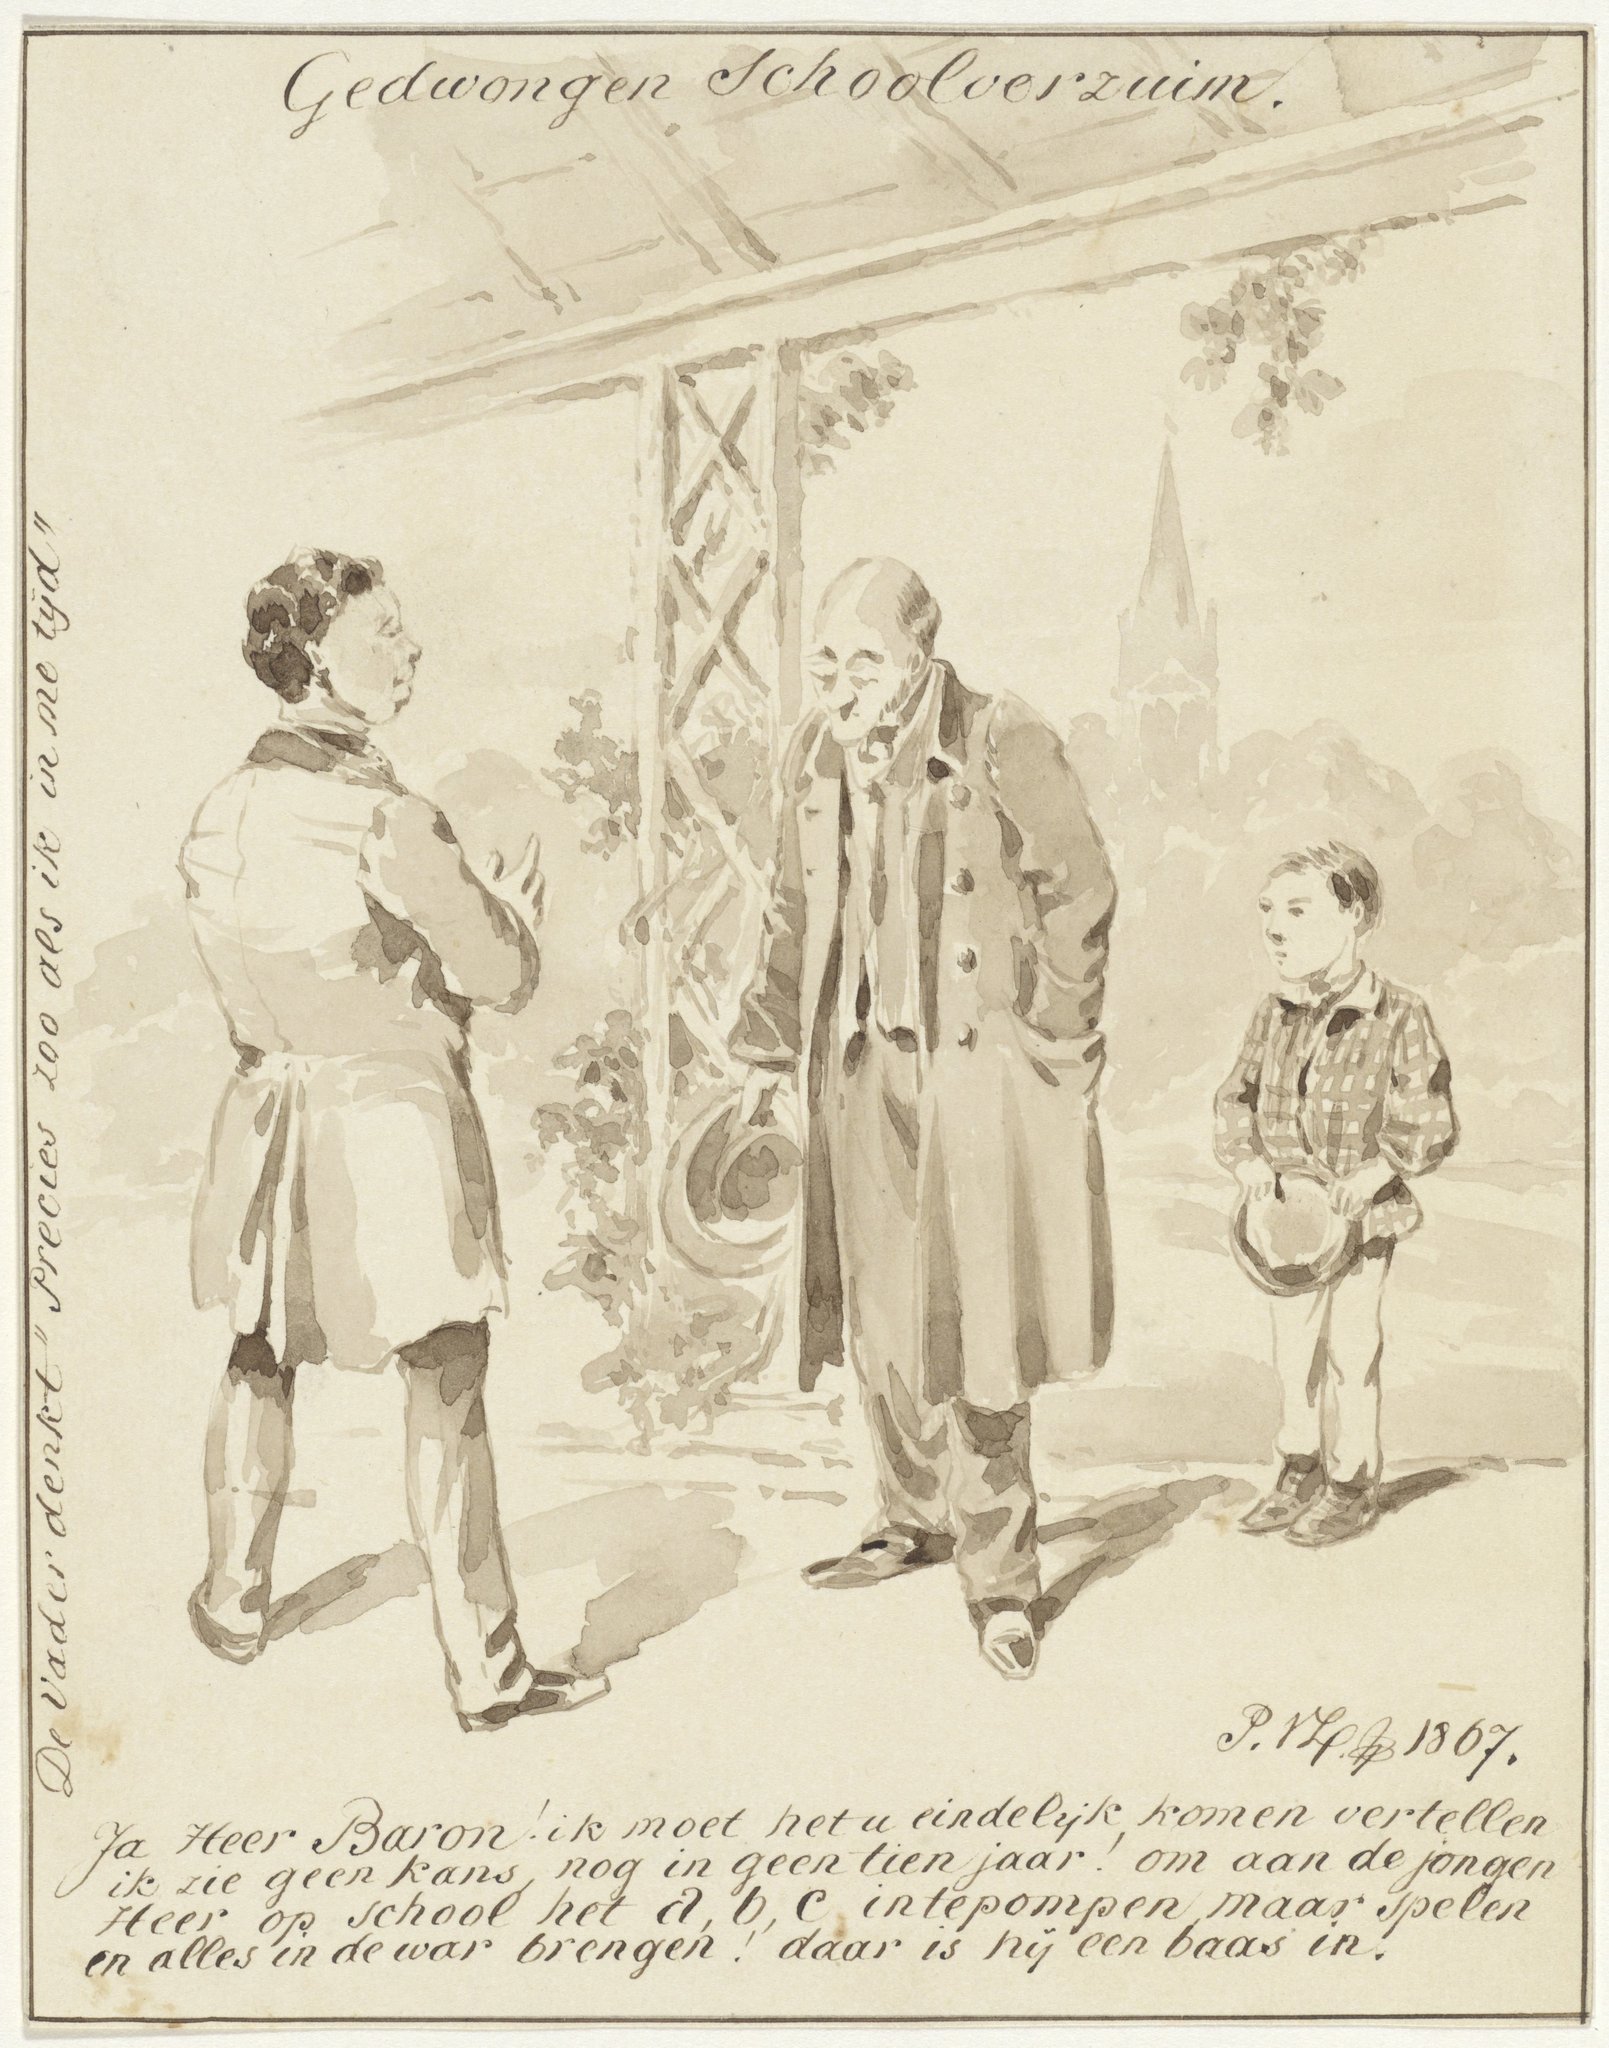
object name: drawing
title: Gedwongen Schoolverzuim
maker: pieter van loon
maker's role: draughtsman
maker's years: 1801-1873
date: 1867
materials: paper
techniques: brush, pen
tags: teacher and pupil